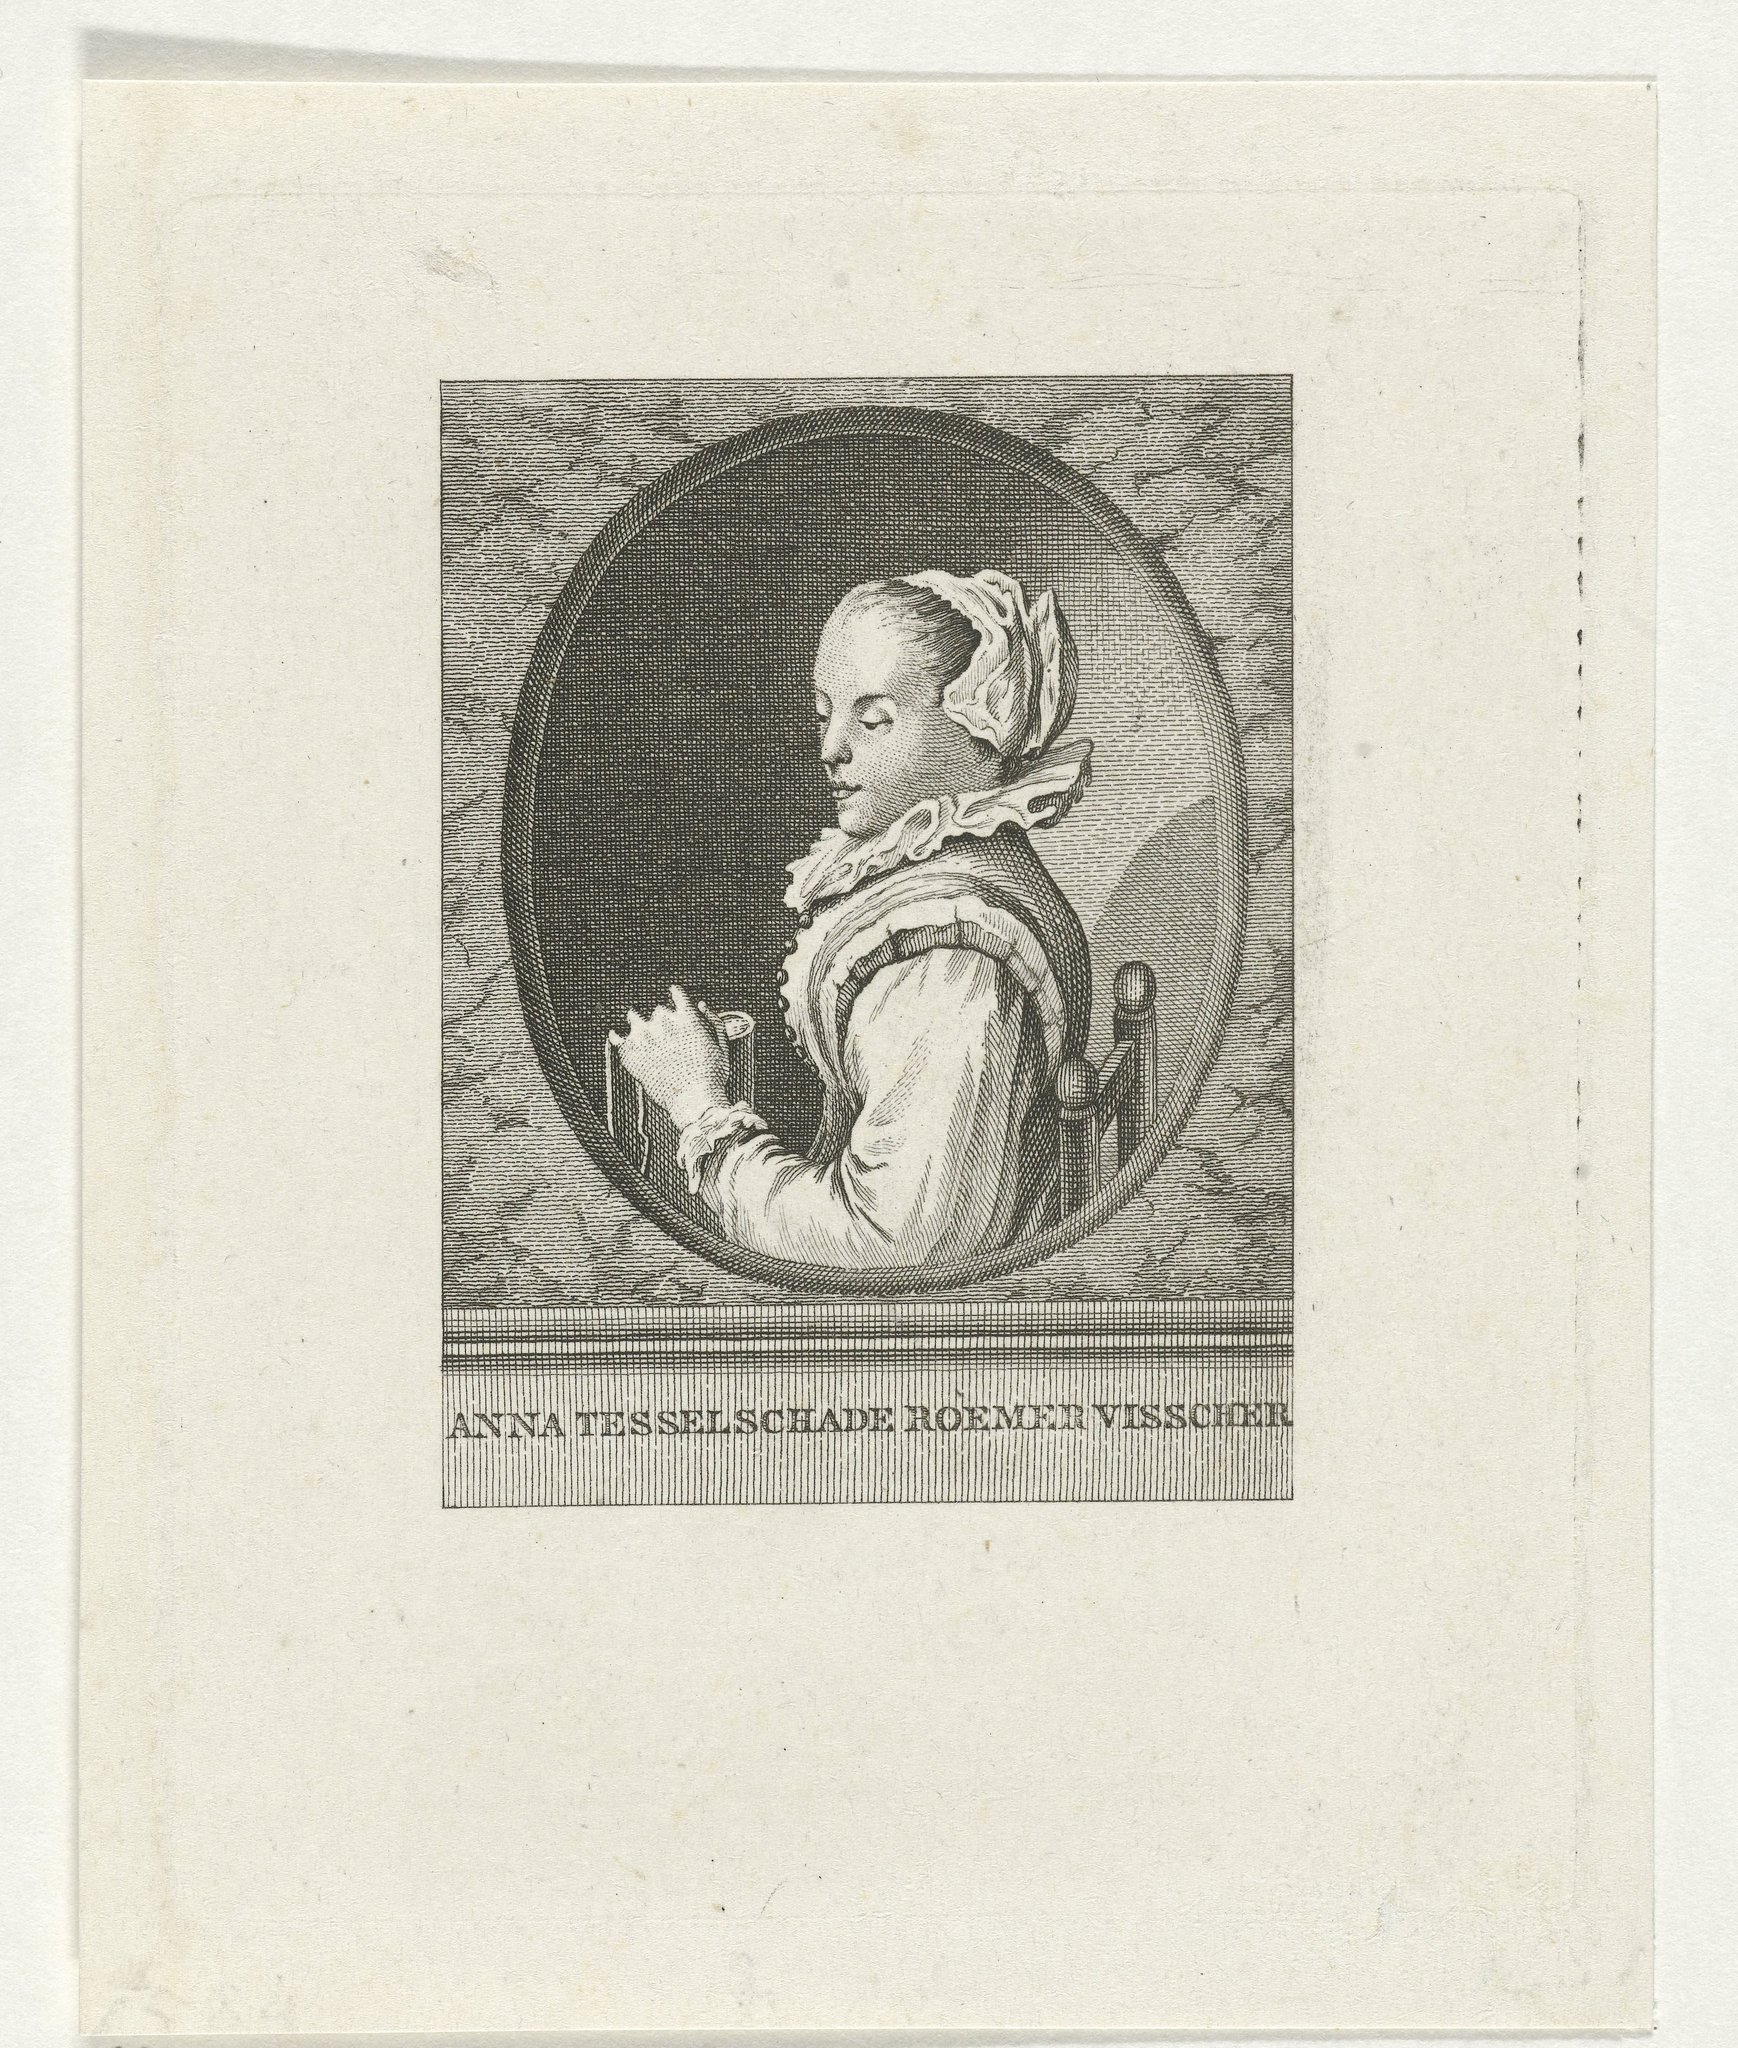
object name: print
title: Portret van Anna Roemers Visscher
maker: carel jacob de huyser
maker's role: print maker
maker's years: 1743-1804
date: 1763-1804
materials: paper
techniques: engraving, etching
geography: amsterdam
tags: amsterdam, anna roemers visscher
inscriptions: collector's mark: Lugt 2228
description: Anna Roemers Visscher, dichteres en glasgraveerster, zittende op een stoel, een boek in haar linkerhand. Portret ten halven lijve naar links in een ovale lijst.